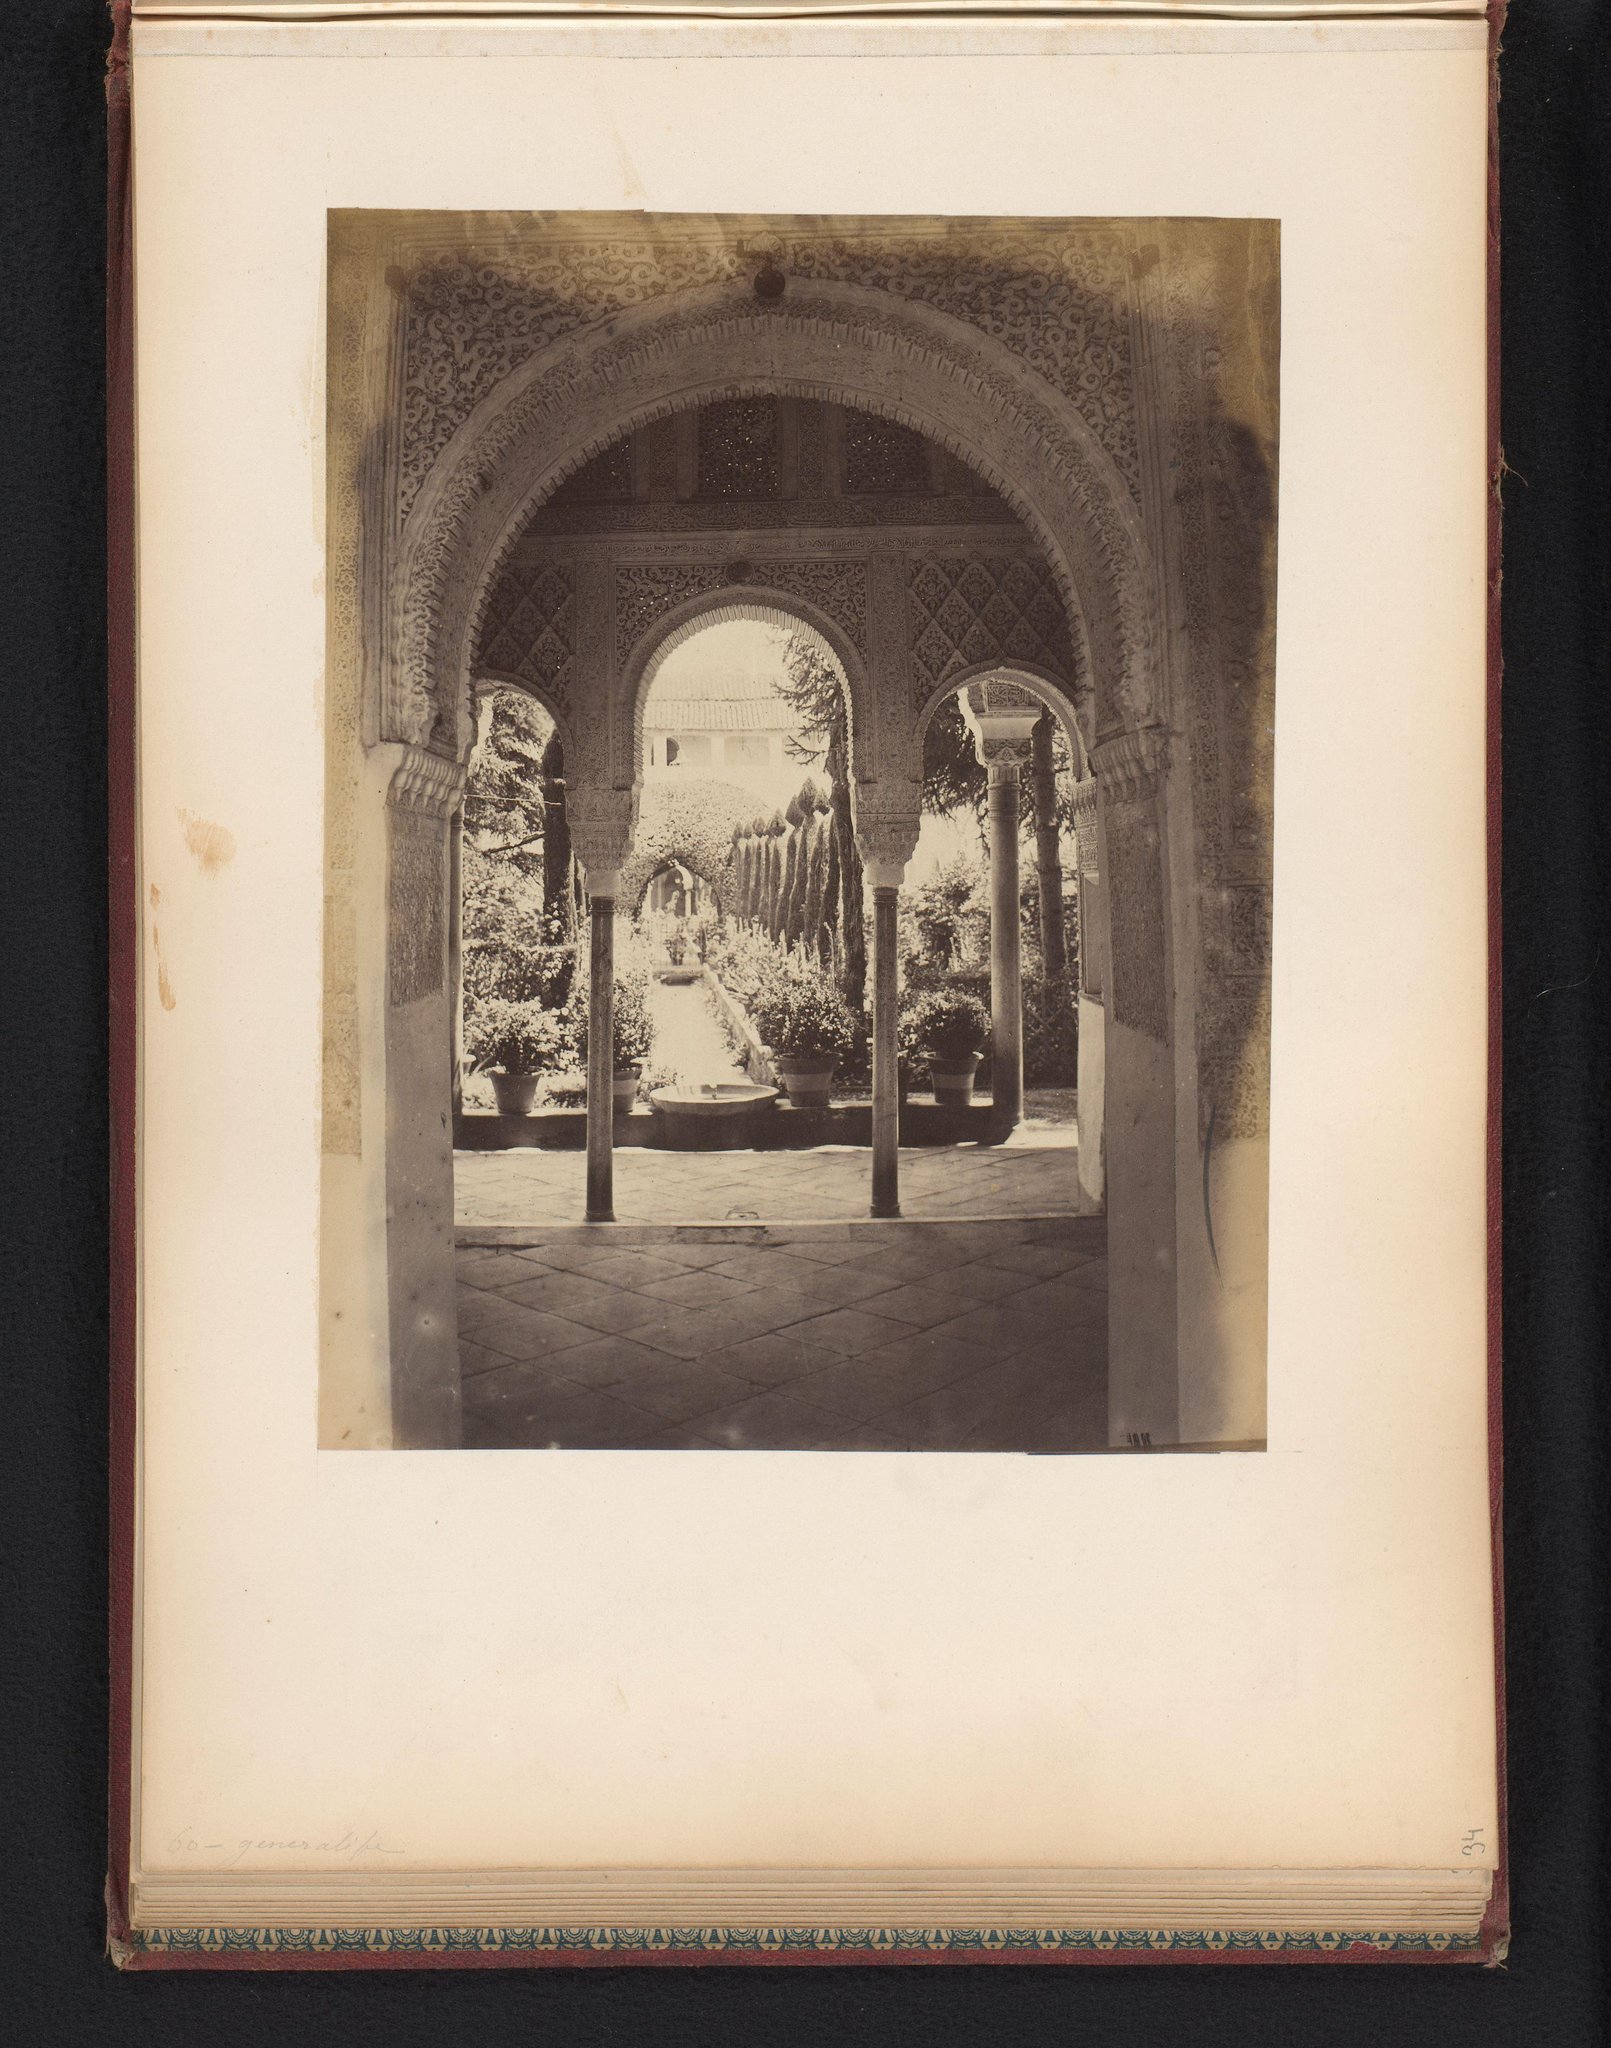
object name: album leaf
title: Generalife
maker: c maufsaise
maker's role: fotograaf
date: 1906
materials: paper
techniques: albumen print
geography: granada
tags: inner court of palace or 'hôtel'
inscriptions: number: ‘60’